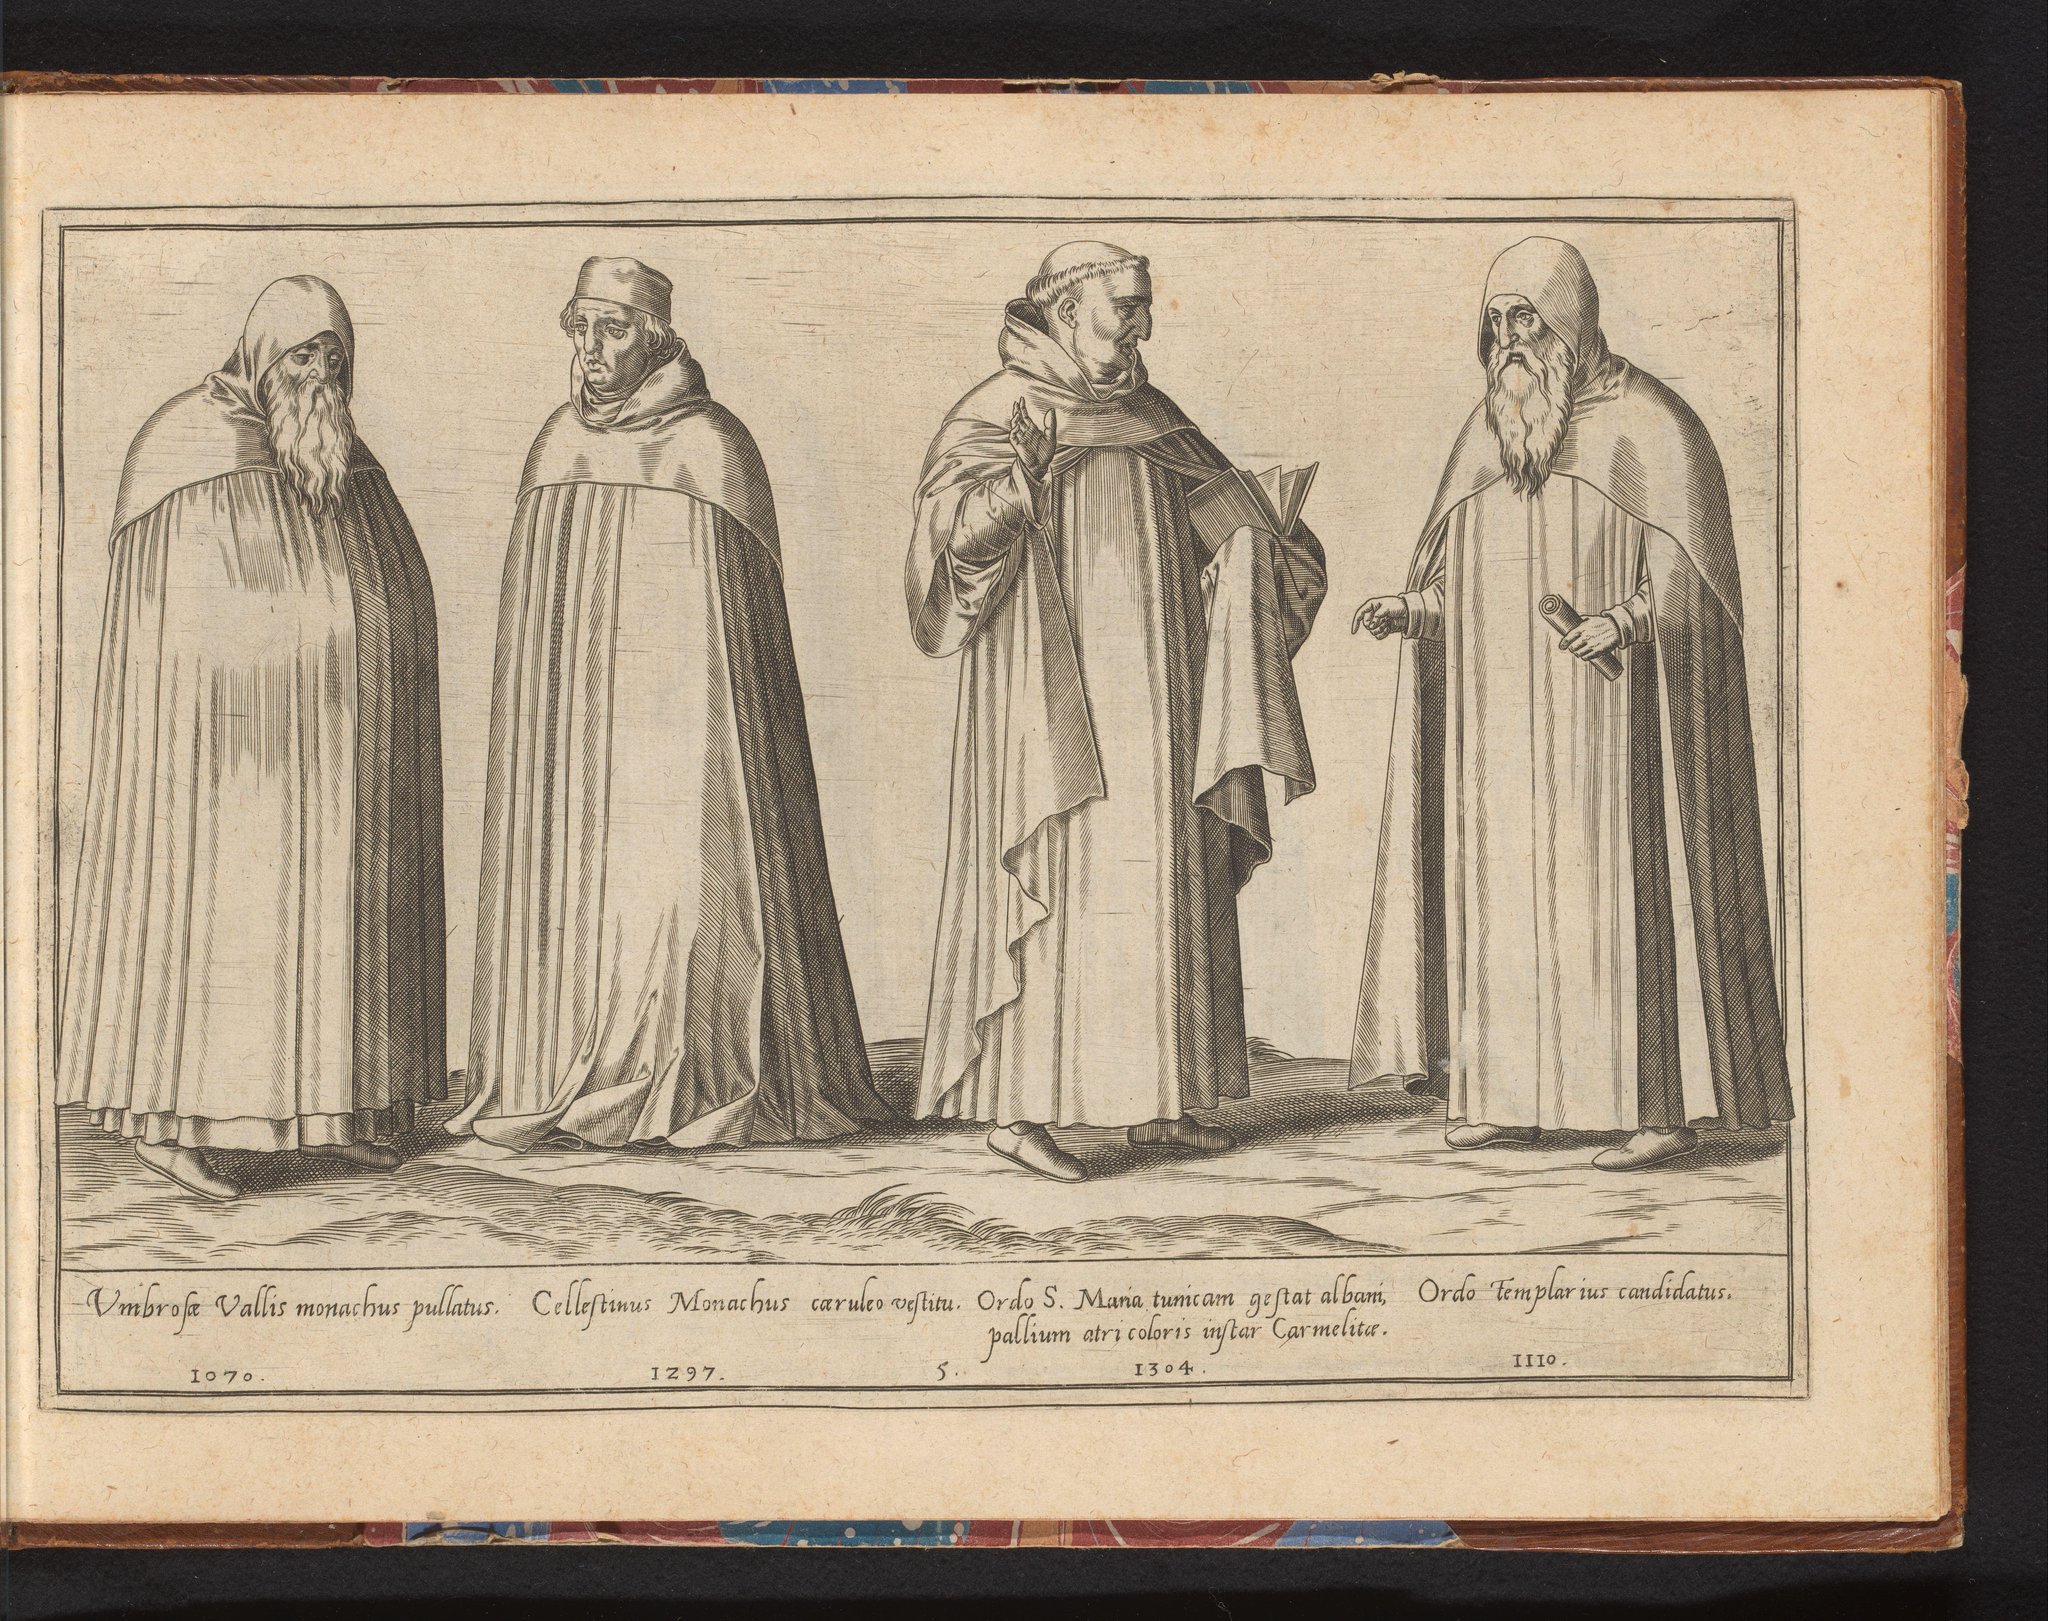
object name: album leaf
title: Vier monniken uit verschillende orden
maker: abraham de bruyn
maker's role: print maker, publisher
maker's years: 1540-1587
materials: paper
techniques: engraving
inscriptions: number: ‘5’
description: Prent uit het boek 'Omnium pene Europae, Asiae, Aphricae atque Americae gentium habitus...', 1581. De prent maakt deel uit van een album.